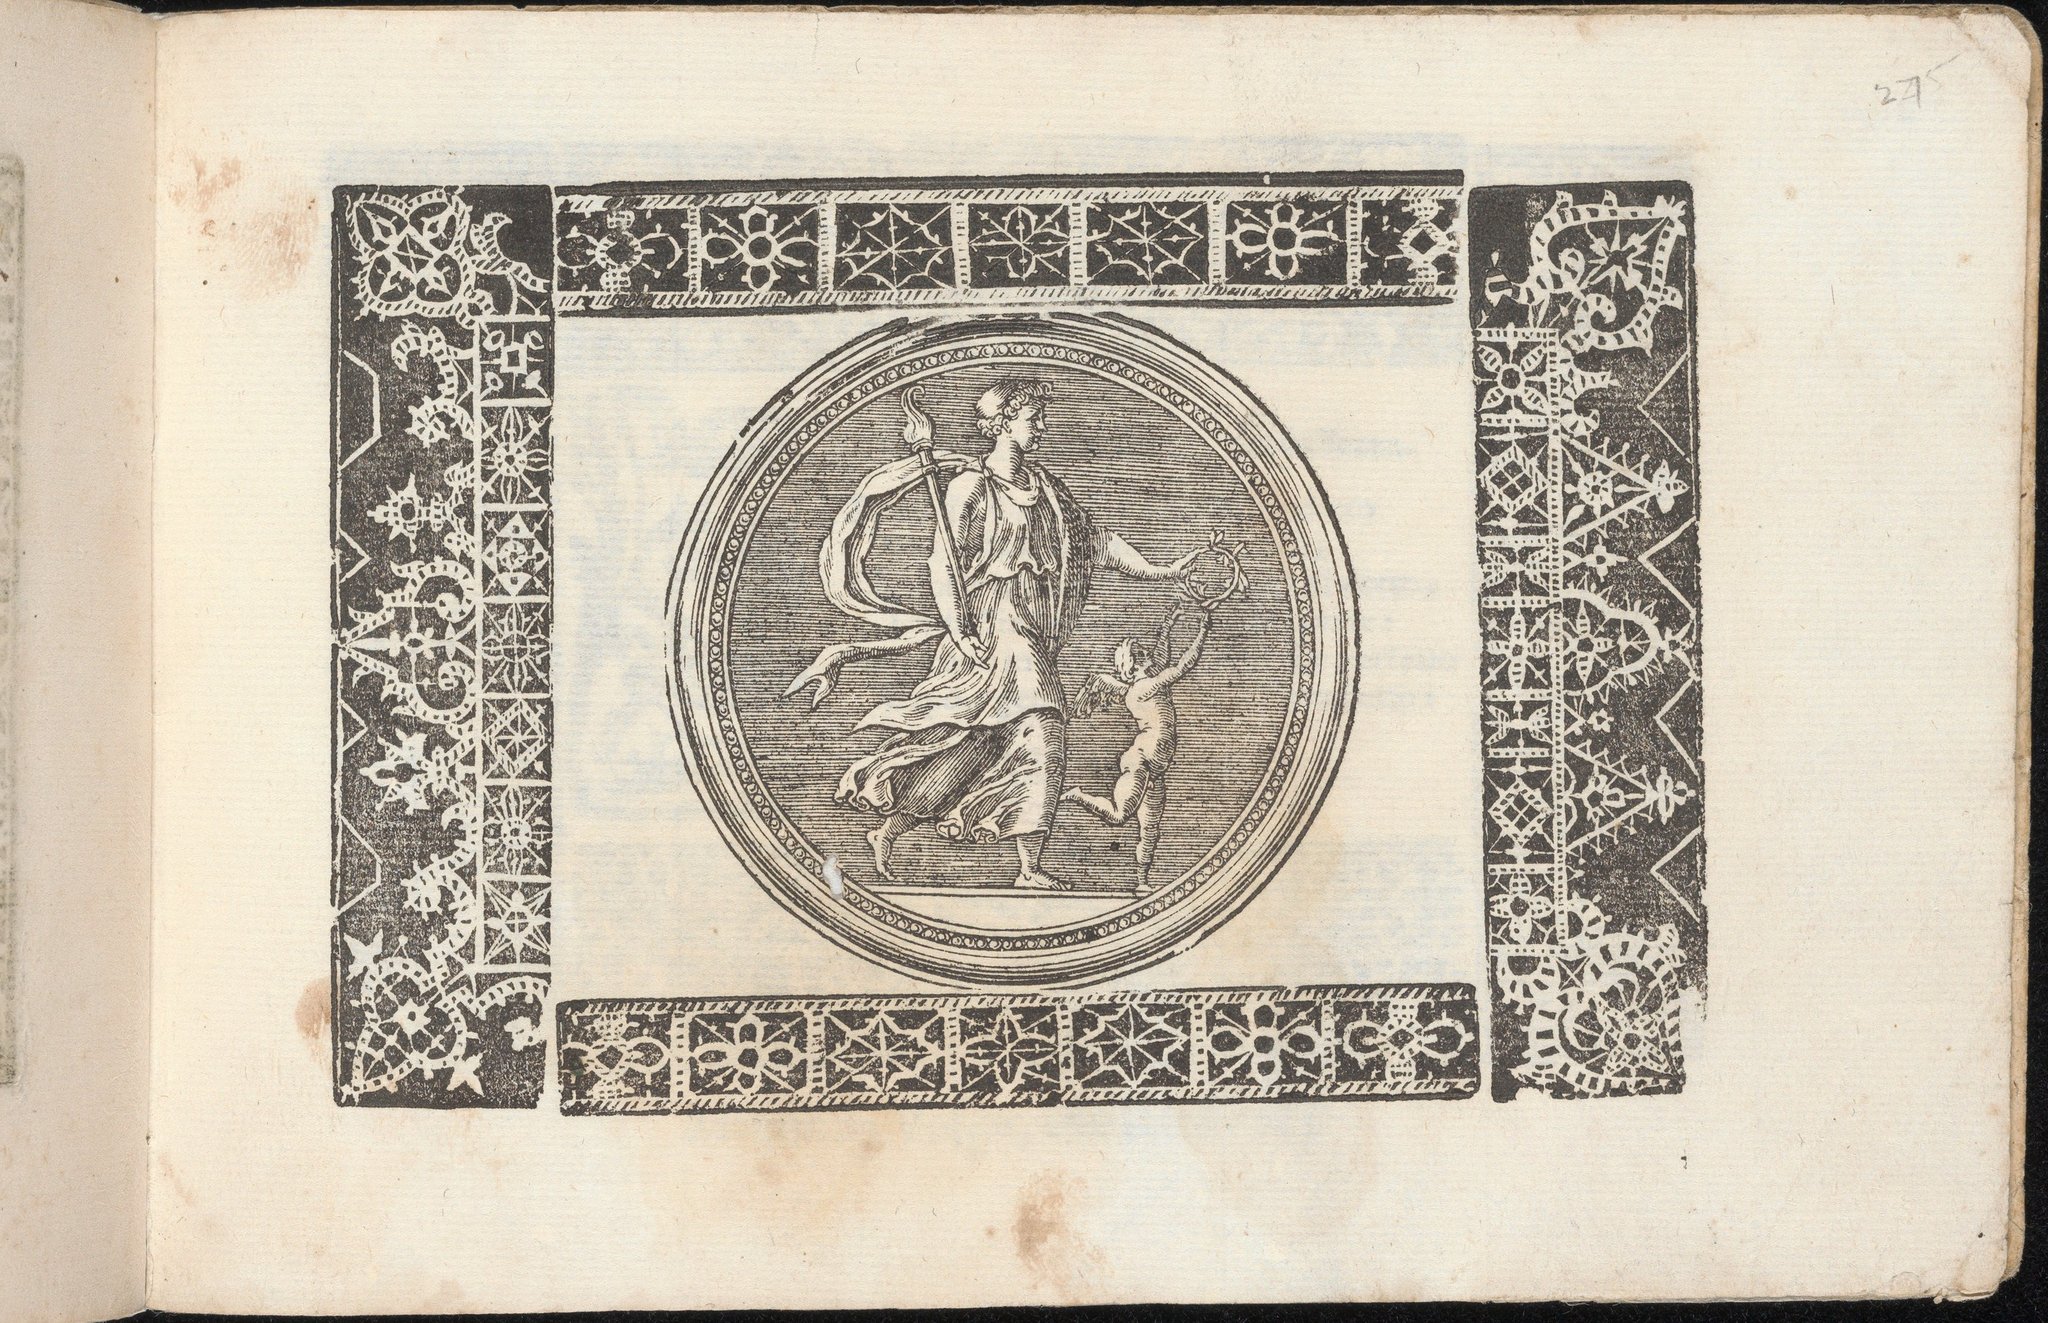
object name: book print ornament architecture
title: Corona delle Nobile et Virtuose Donne, Libro Terzo, page 27 (recto)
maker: cesare vecellio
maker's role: designer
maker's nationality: italian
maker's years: 1521-1601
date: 1620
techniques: woodcut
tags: ornament